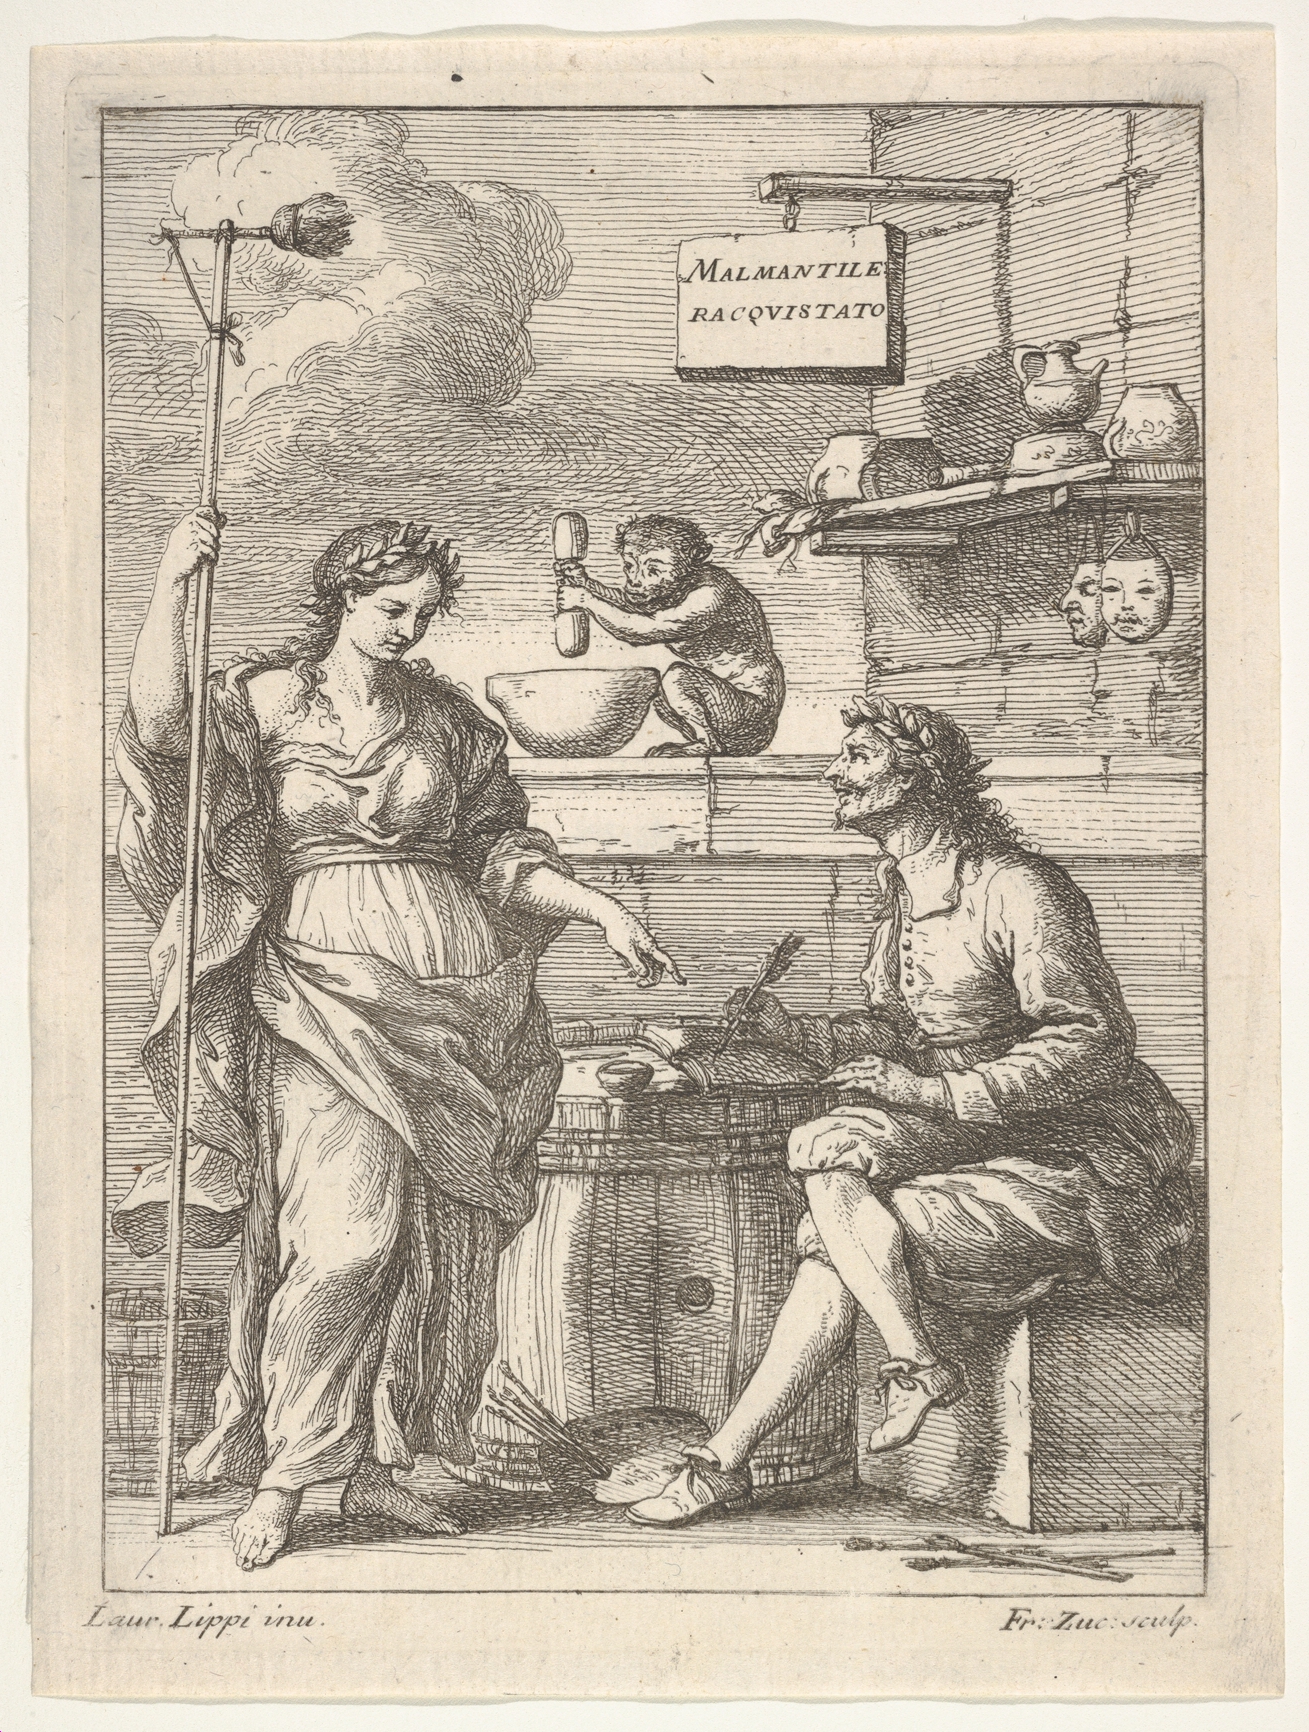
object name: print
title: A monkey working a mortar and pestle, below Lorenzo Lippi (?) writing his humorous poem "Malmantile Racquistato", a muse standing at left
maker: francesco zucchi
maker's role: artist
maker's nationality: italian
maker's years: 1692-1764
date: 1710-1764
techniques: etching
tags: men,women,monkeys,writing